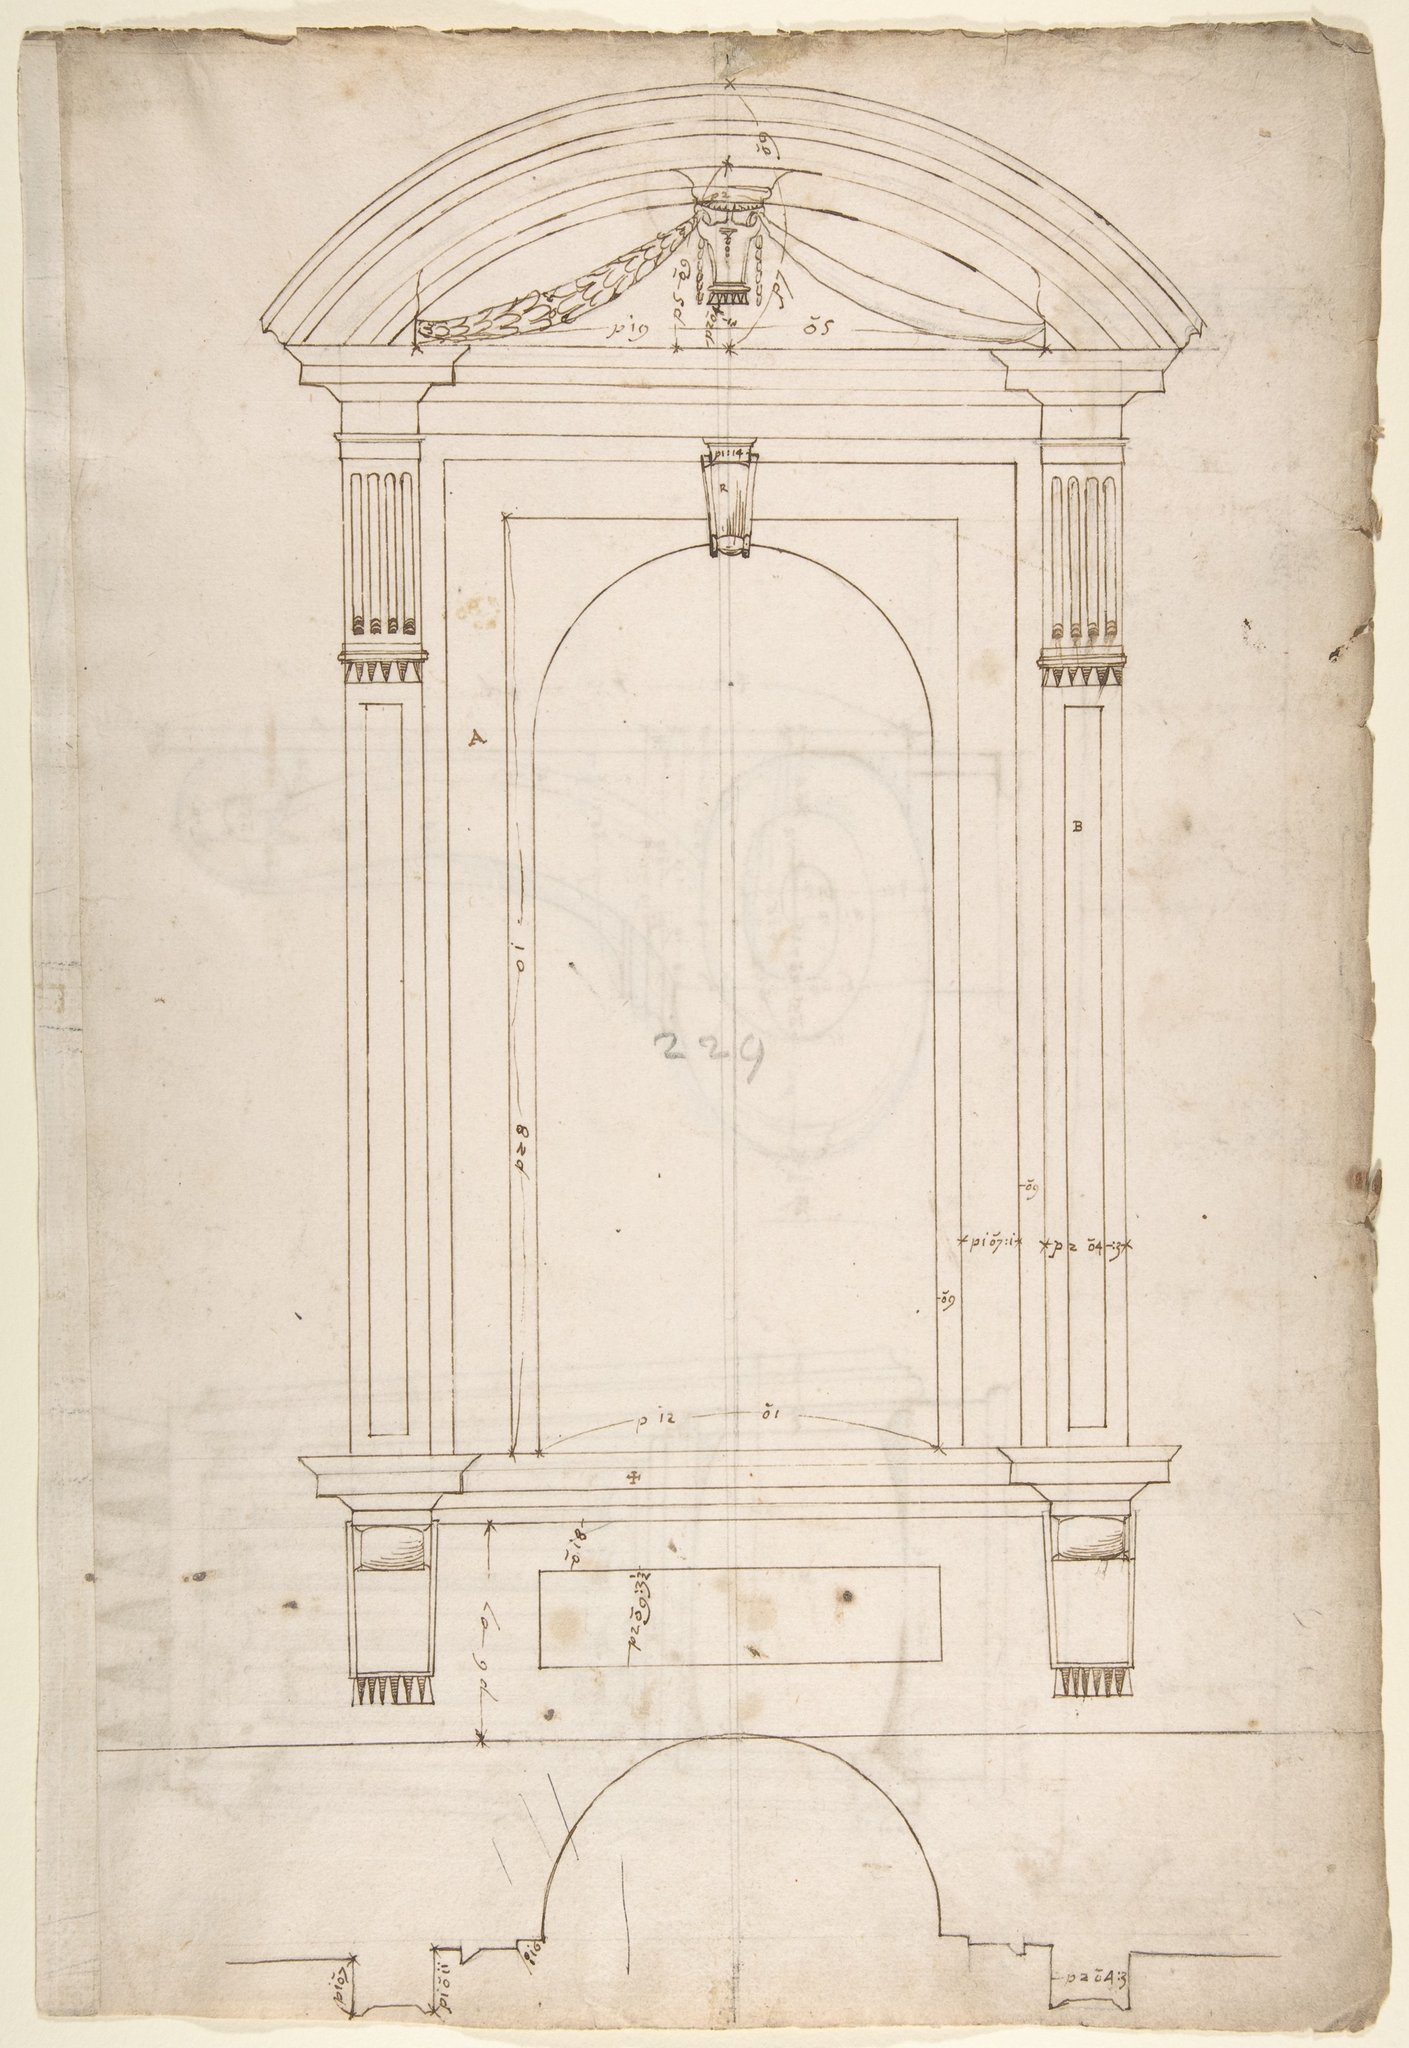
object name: drawing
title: St. Peter's, apse, exterior niche details (recto) St Peter's, apse, exterior niche elevation and profile of scrolled console, elevation of column shaft (verso)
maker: anonymous, french, 16th century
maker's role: draftsman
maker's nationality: french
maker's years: 1500-1600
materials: chalk, ink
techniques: incising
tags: architecture